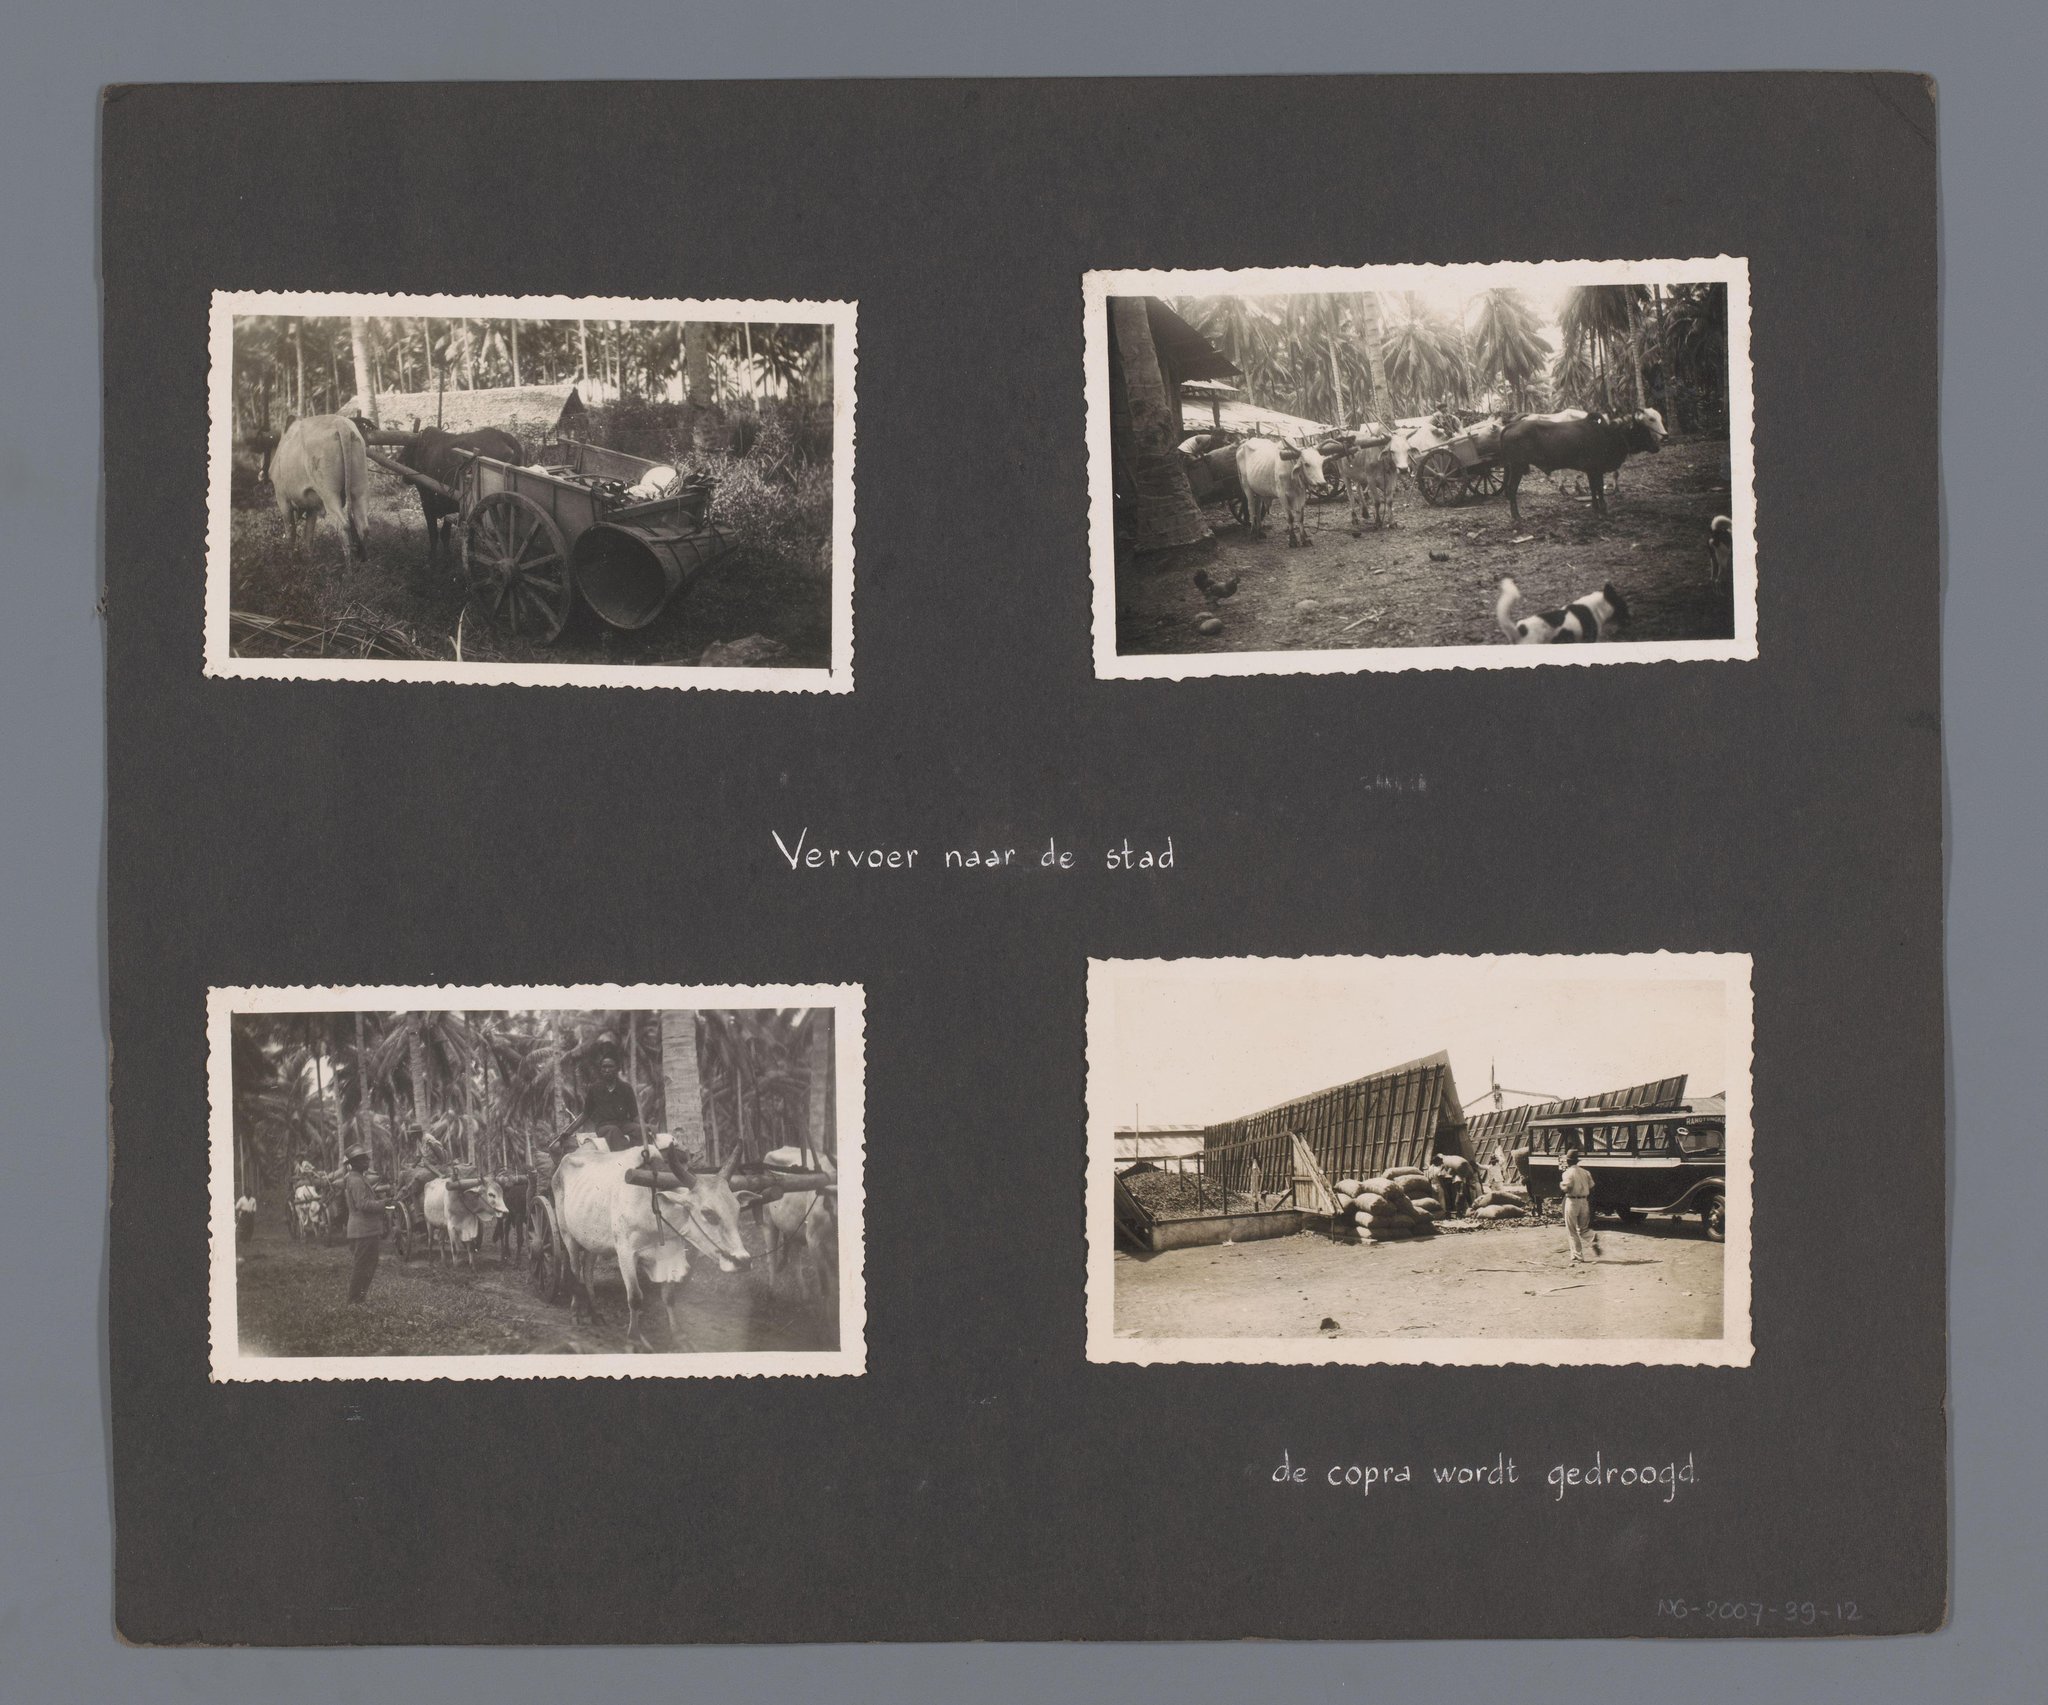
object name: album leaf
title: Vervoer naar de stad / de copra wordt gedroogd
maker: Anonymous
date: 1930-1939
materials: paper, photographic support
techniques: gelatin silver print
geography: celebes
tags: plantation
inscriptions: annotation: ‘Vervoer naar de stad / de copra wordt gedroogd’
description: Zwart albumblad met vier foto's van het vervoer en de verwerking van kopra. Vermoedelijk op Celebes (Sulawesi). Onderdeel van het losbladig fotoalbum over de Fraters van Tilburg op Celebes en Sumatra.